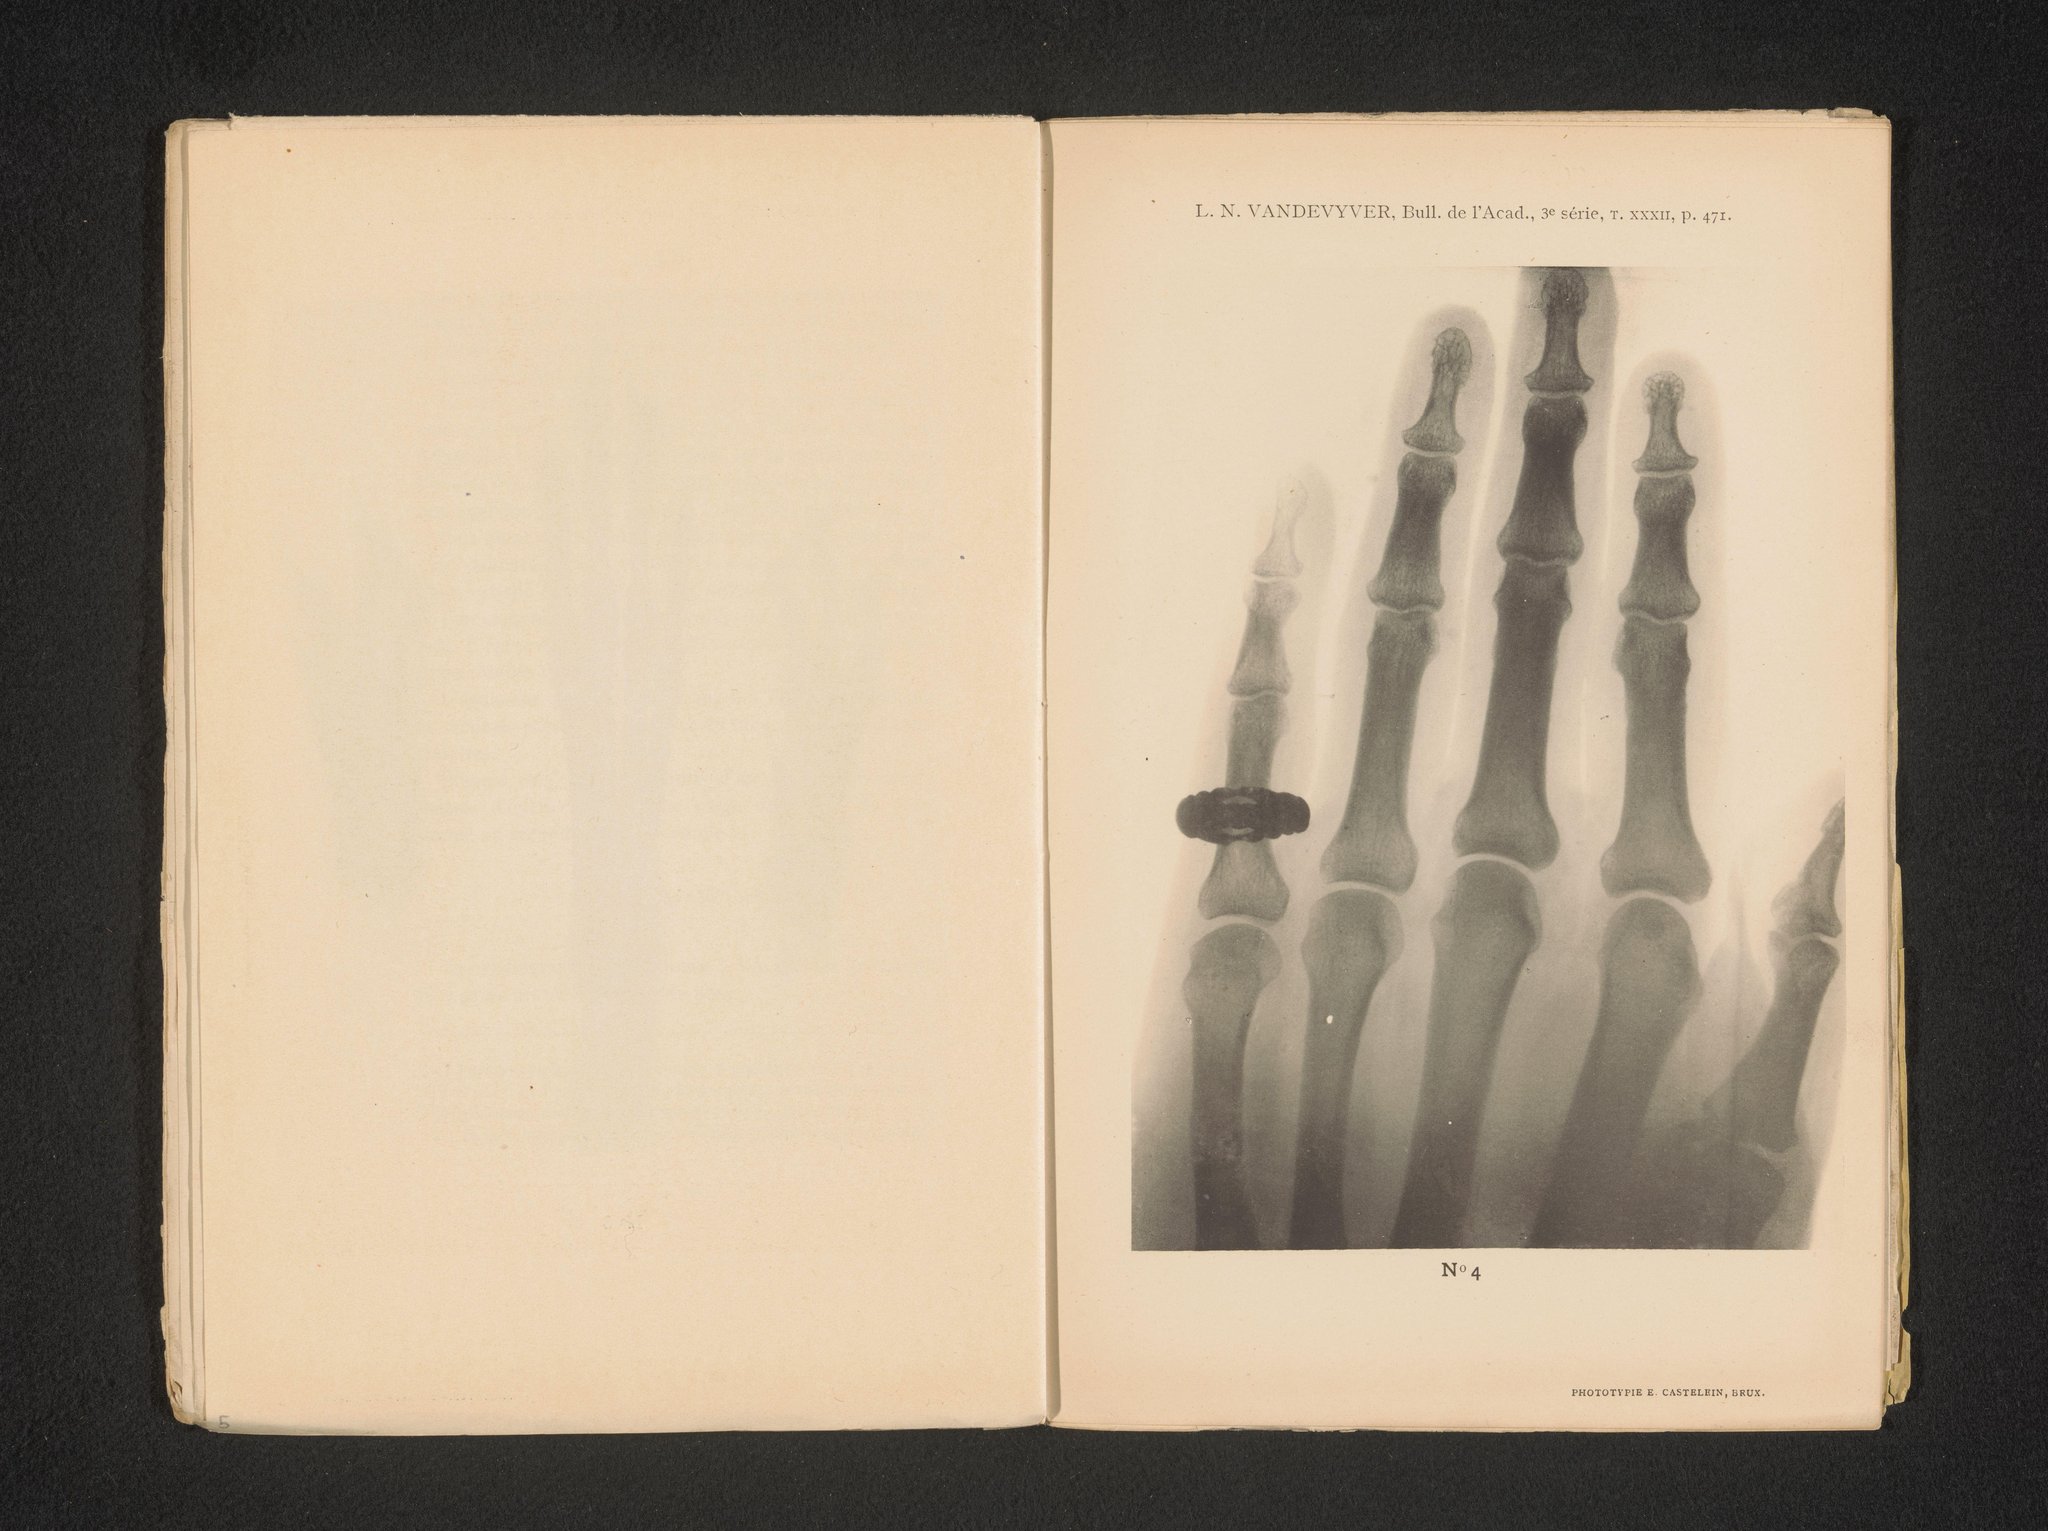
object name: photomechanical print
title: Röntgenfoto van een hand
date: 1891-1896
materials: paper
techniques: photograph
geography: ghent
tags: x-ray examination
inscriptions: number: ‘No 4’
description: Prent op derde ongenummerde pagina na pagina 470.